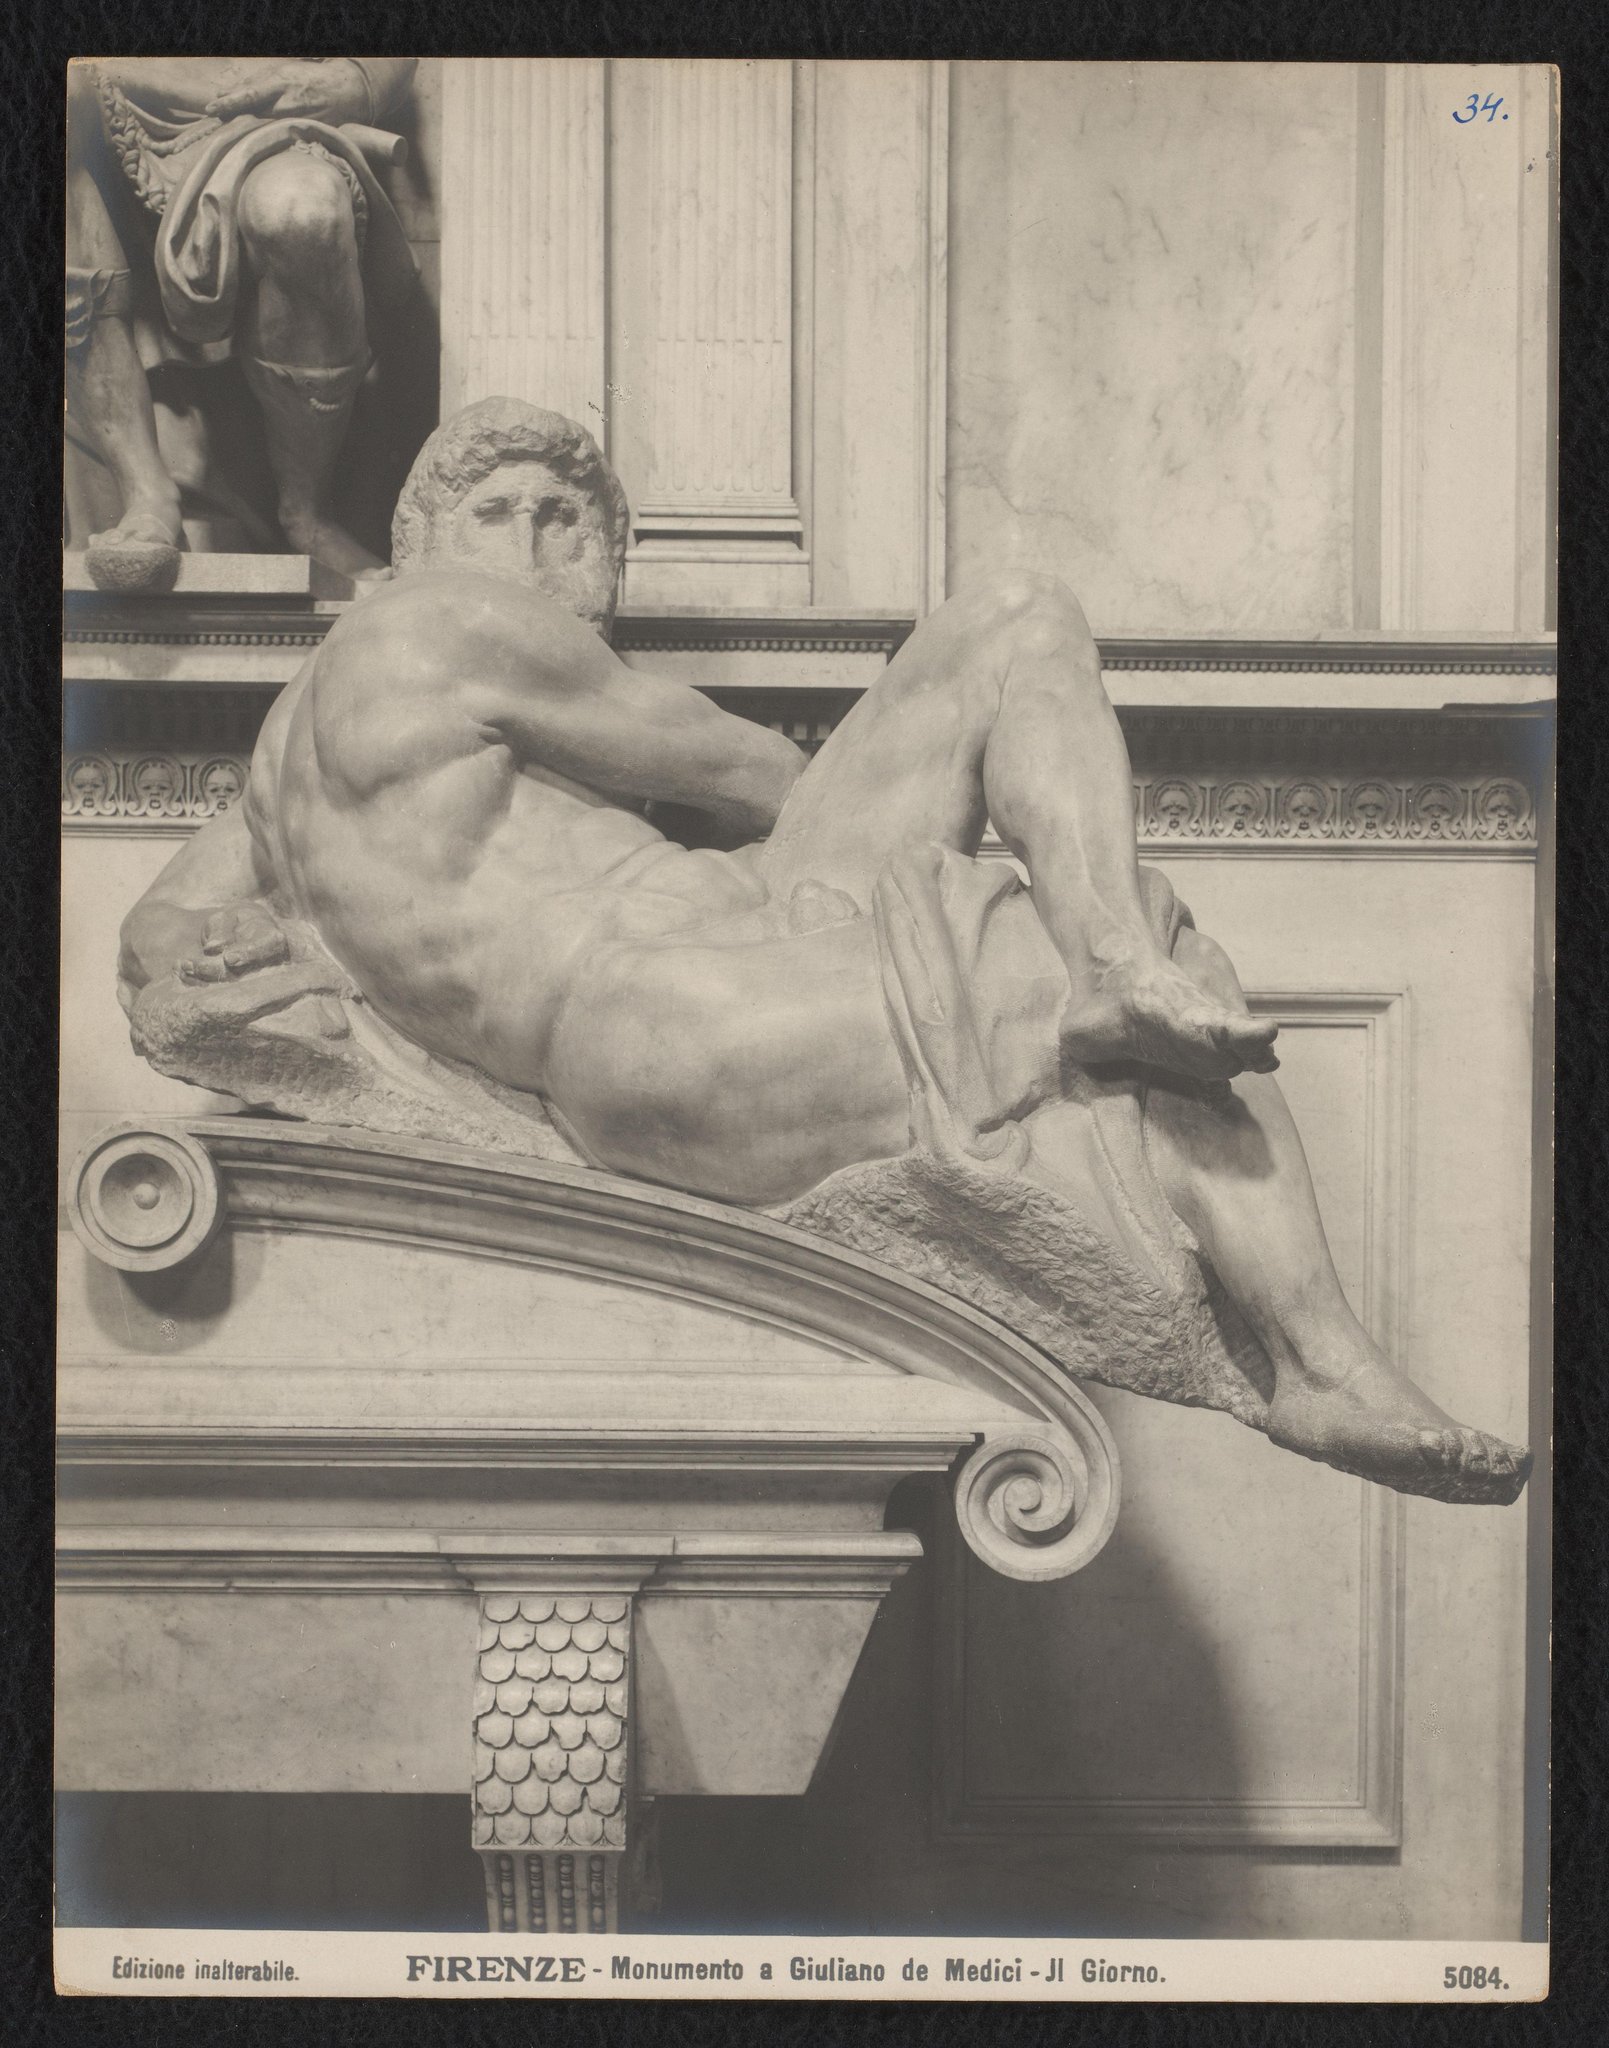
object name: photograph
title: Firenze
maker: Anonymous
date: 1900-1920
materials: paper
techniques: gelatin silver print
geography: florence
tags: grave-building, monumental tomb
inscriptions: number: ‘34.’, number: ‘5084.’, inscription: ‘Edizione inalterabile.’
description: Deze foto maakt deel uit van een omslag.